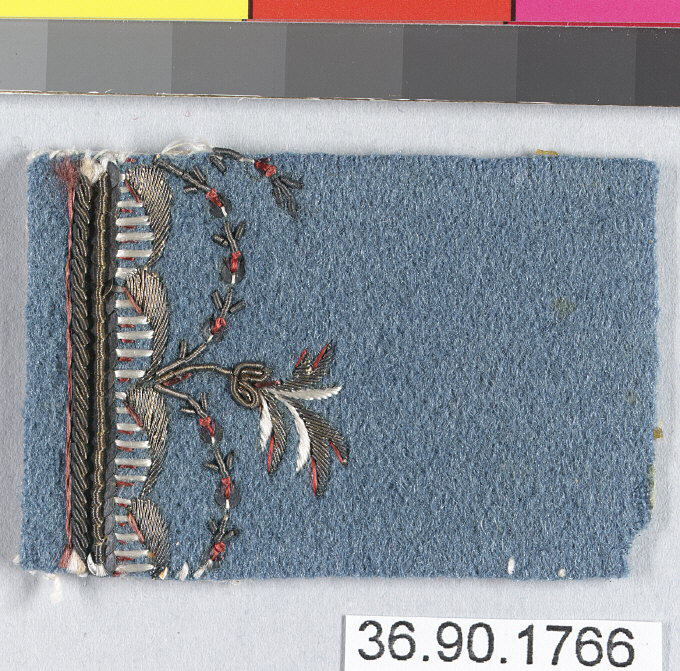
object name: sample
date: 1801-1833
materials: felt, metal thread, silk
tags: plants